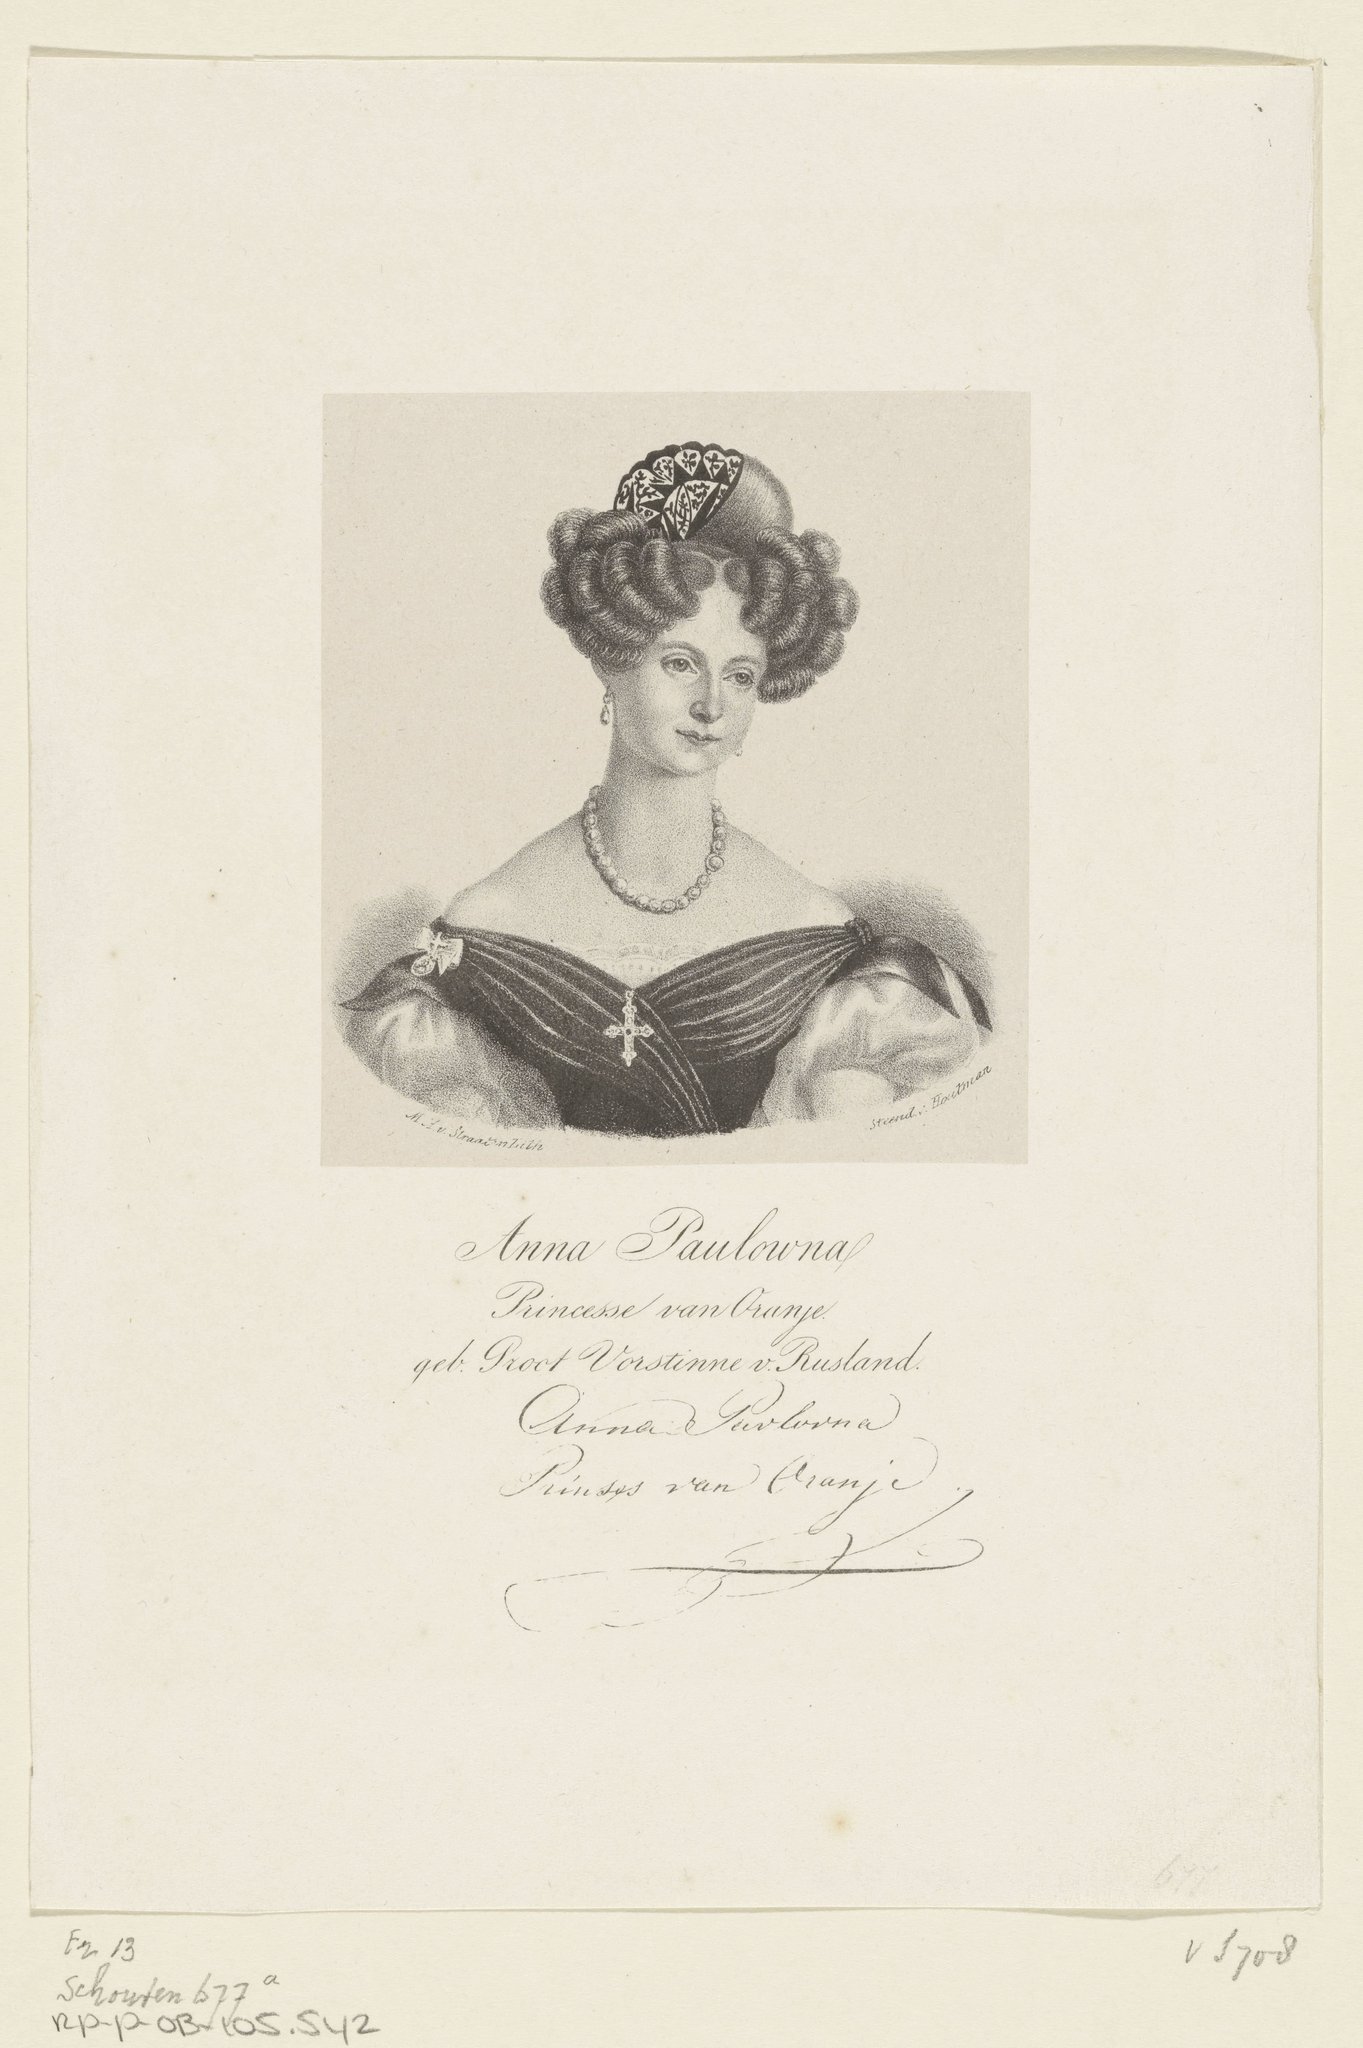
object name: print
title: Portret van Anna Paulowna Romanowa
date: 1818-1845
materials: paper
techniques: lithograph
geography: utrecht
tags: the hague, anna paulowna romanowa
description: Portret van Anna Paulowna. In de ondermarge haar naam, haar titels en haar handtekening.